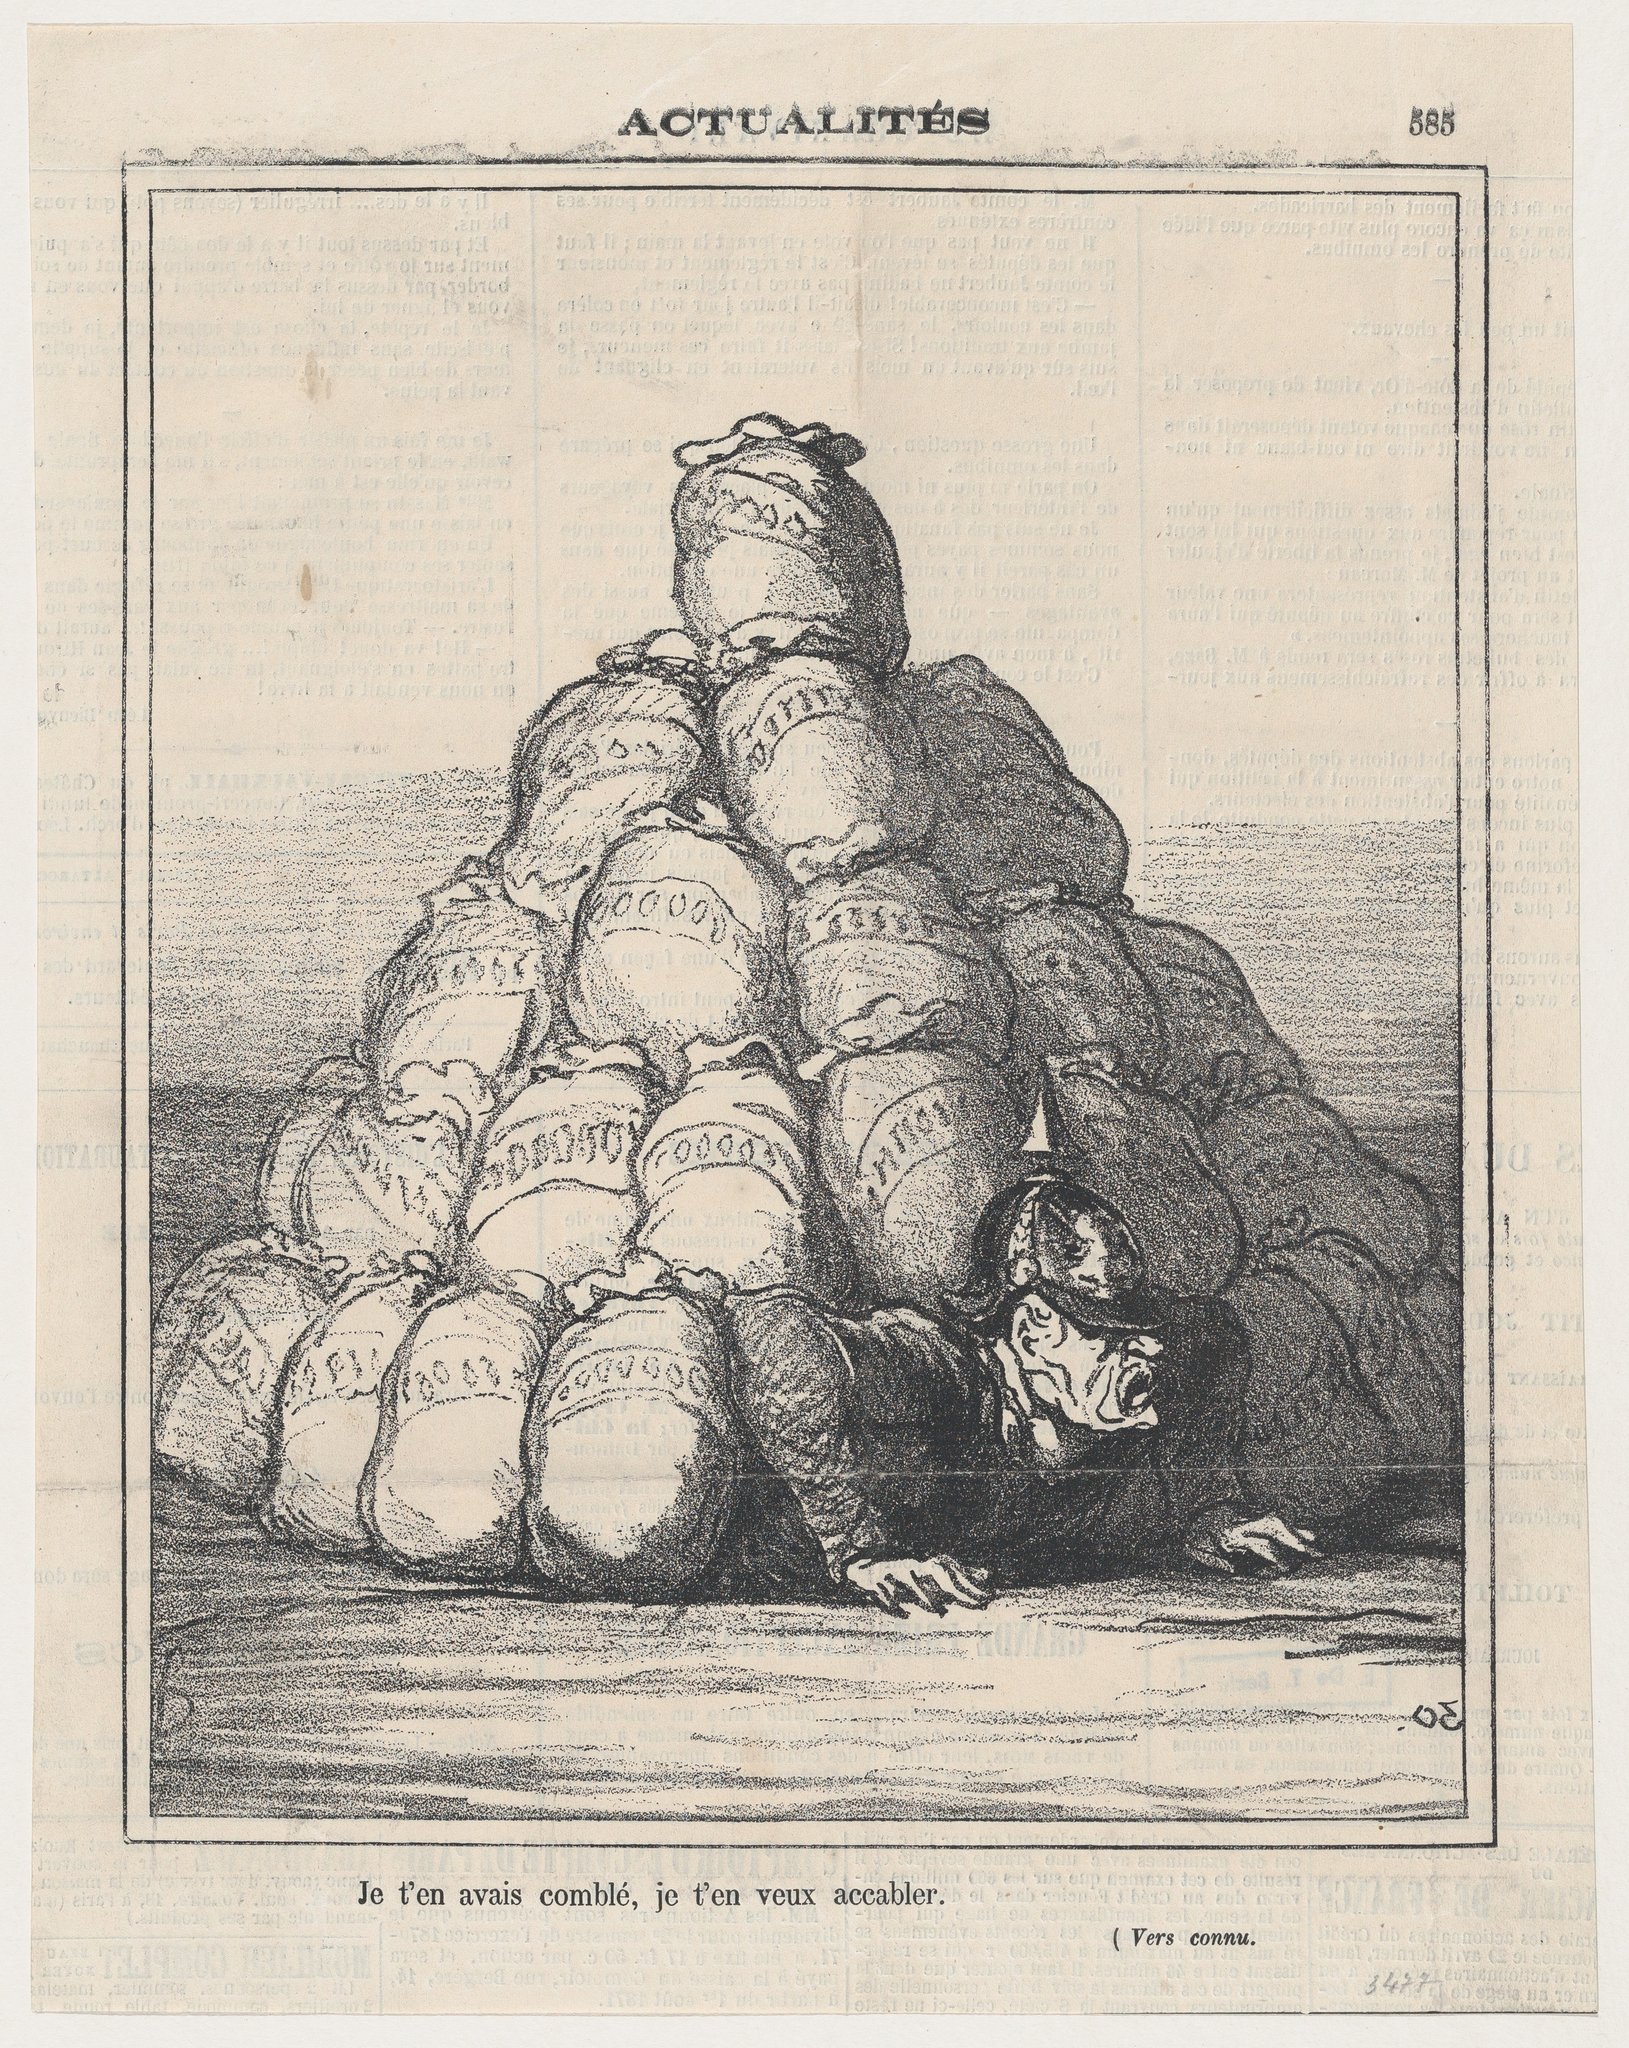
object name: print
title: I have filled you up full to the top. I wished it would crush you, from "News of the day"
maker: honoré daumier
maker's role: artist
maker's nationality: french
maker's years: 1808-1879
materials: paper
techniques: lithograph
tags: satire,men